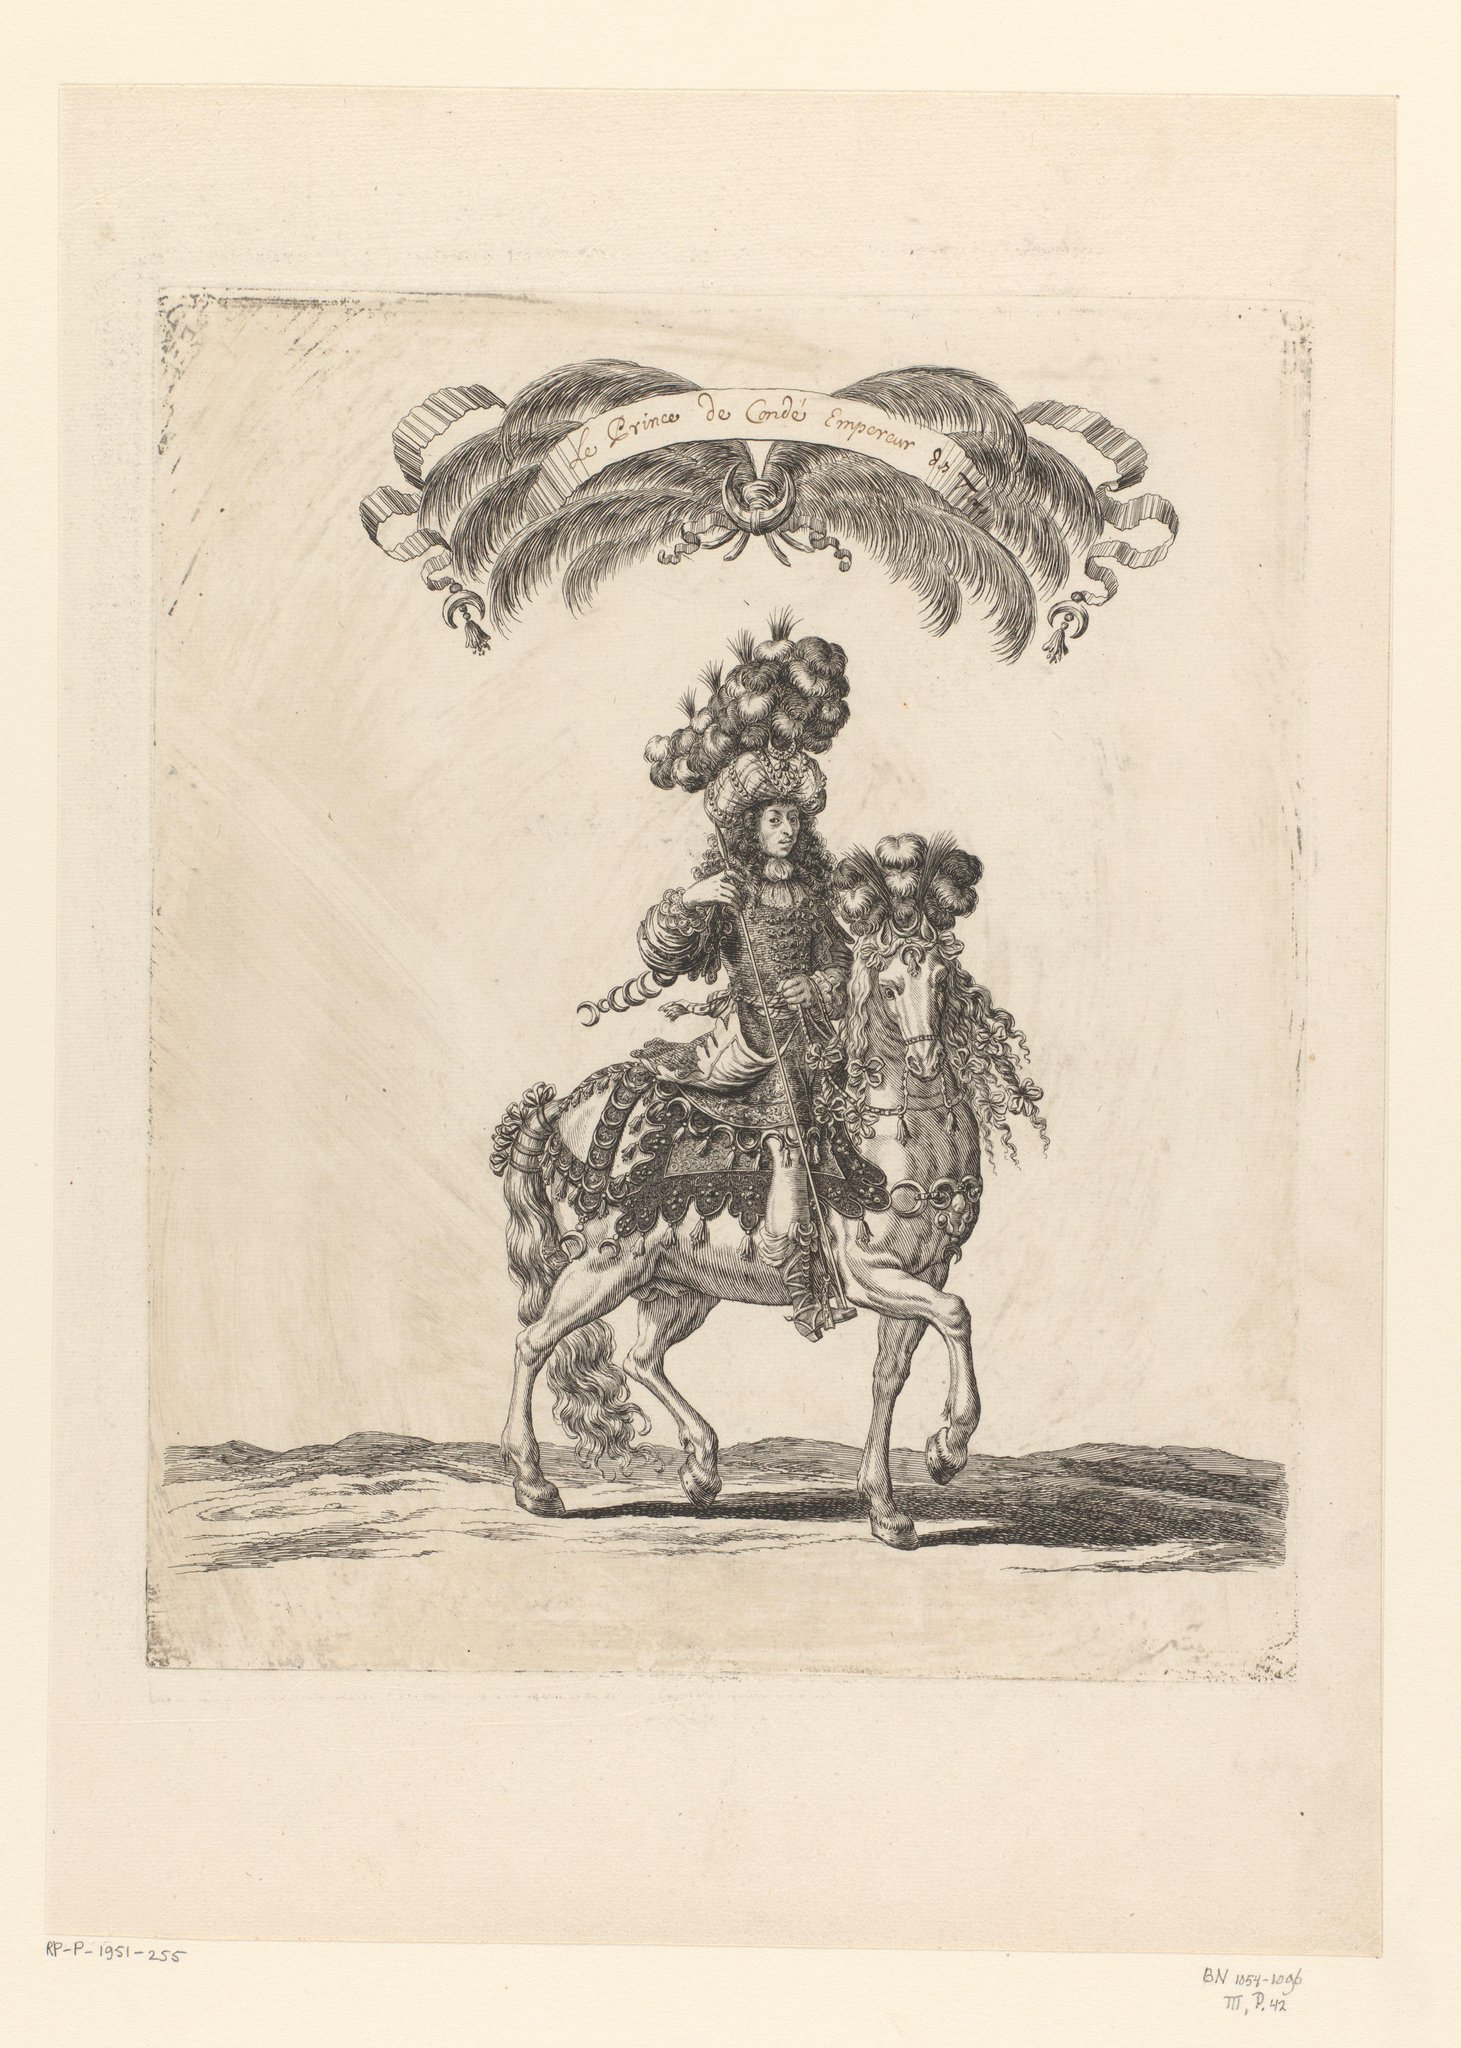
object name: book illustration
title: Le Prince de Condé Empereur des Turcs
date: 1670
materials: paper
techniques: etching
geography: france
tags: lodewijk ii de bourbon-condé (hertog van enghien), tournament, historical persons, horse, festivities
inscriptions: collector's mark: Lugt 2228, inscription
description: Prent uit: Perrault, Charles. Courses de testes et de bague faites par le Roy et par les princes et seigneurs de sa cour en l'année M.DC.LXII. Parijs: Imprimerie Royale, 1670. De prenten illustreren de door Lodewijk XIV georganiseerde festiviteiten in juni 1662 te Tuileries, zoals steekspelen met figuren in verschillende kostuums.